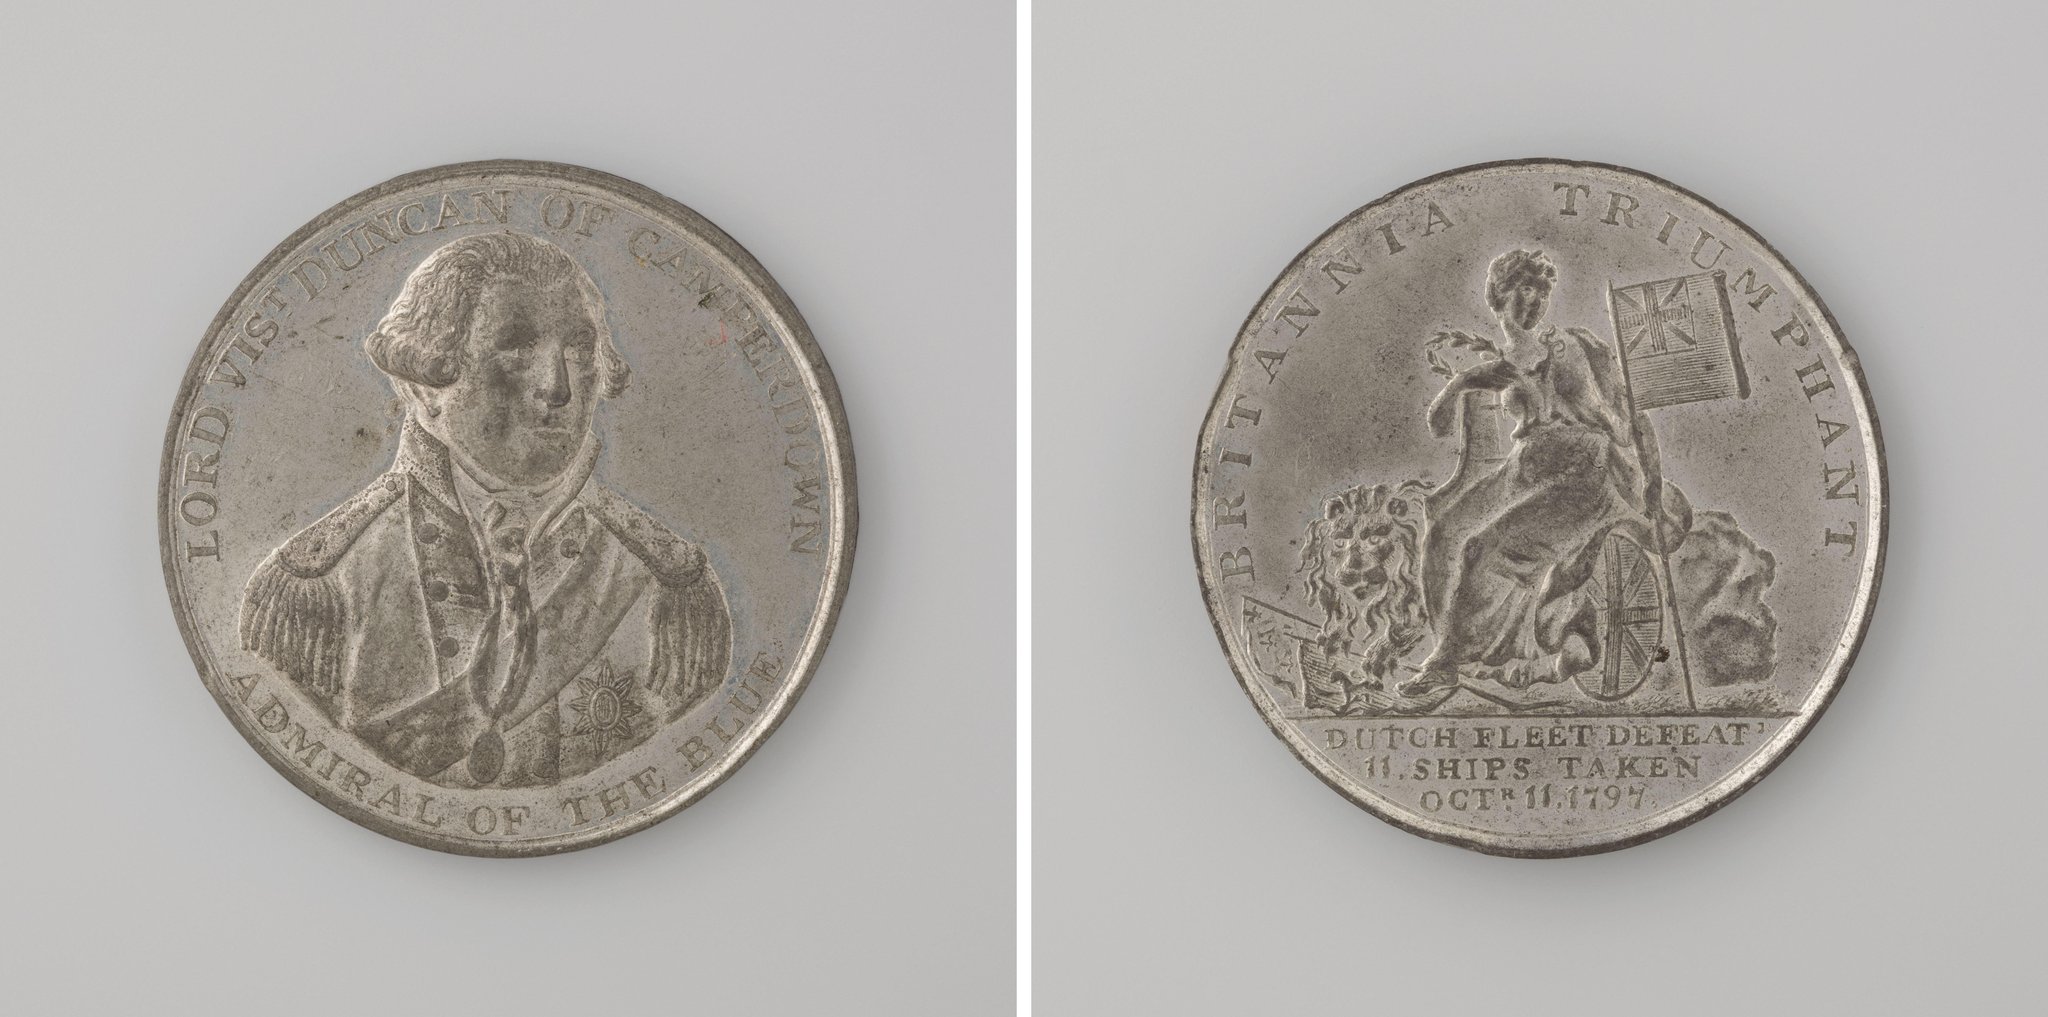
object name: history medal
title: Slag bij Kamperduin, ter ere van Adam Duncan, admiraal van de Britse vloot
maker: Anonymous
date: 1797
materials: silver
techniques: striking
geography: england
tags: adam duncan (burggraaf van duncan), battle of camperdown